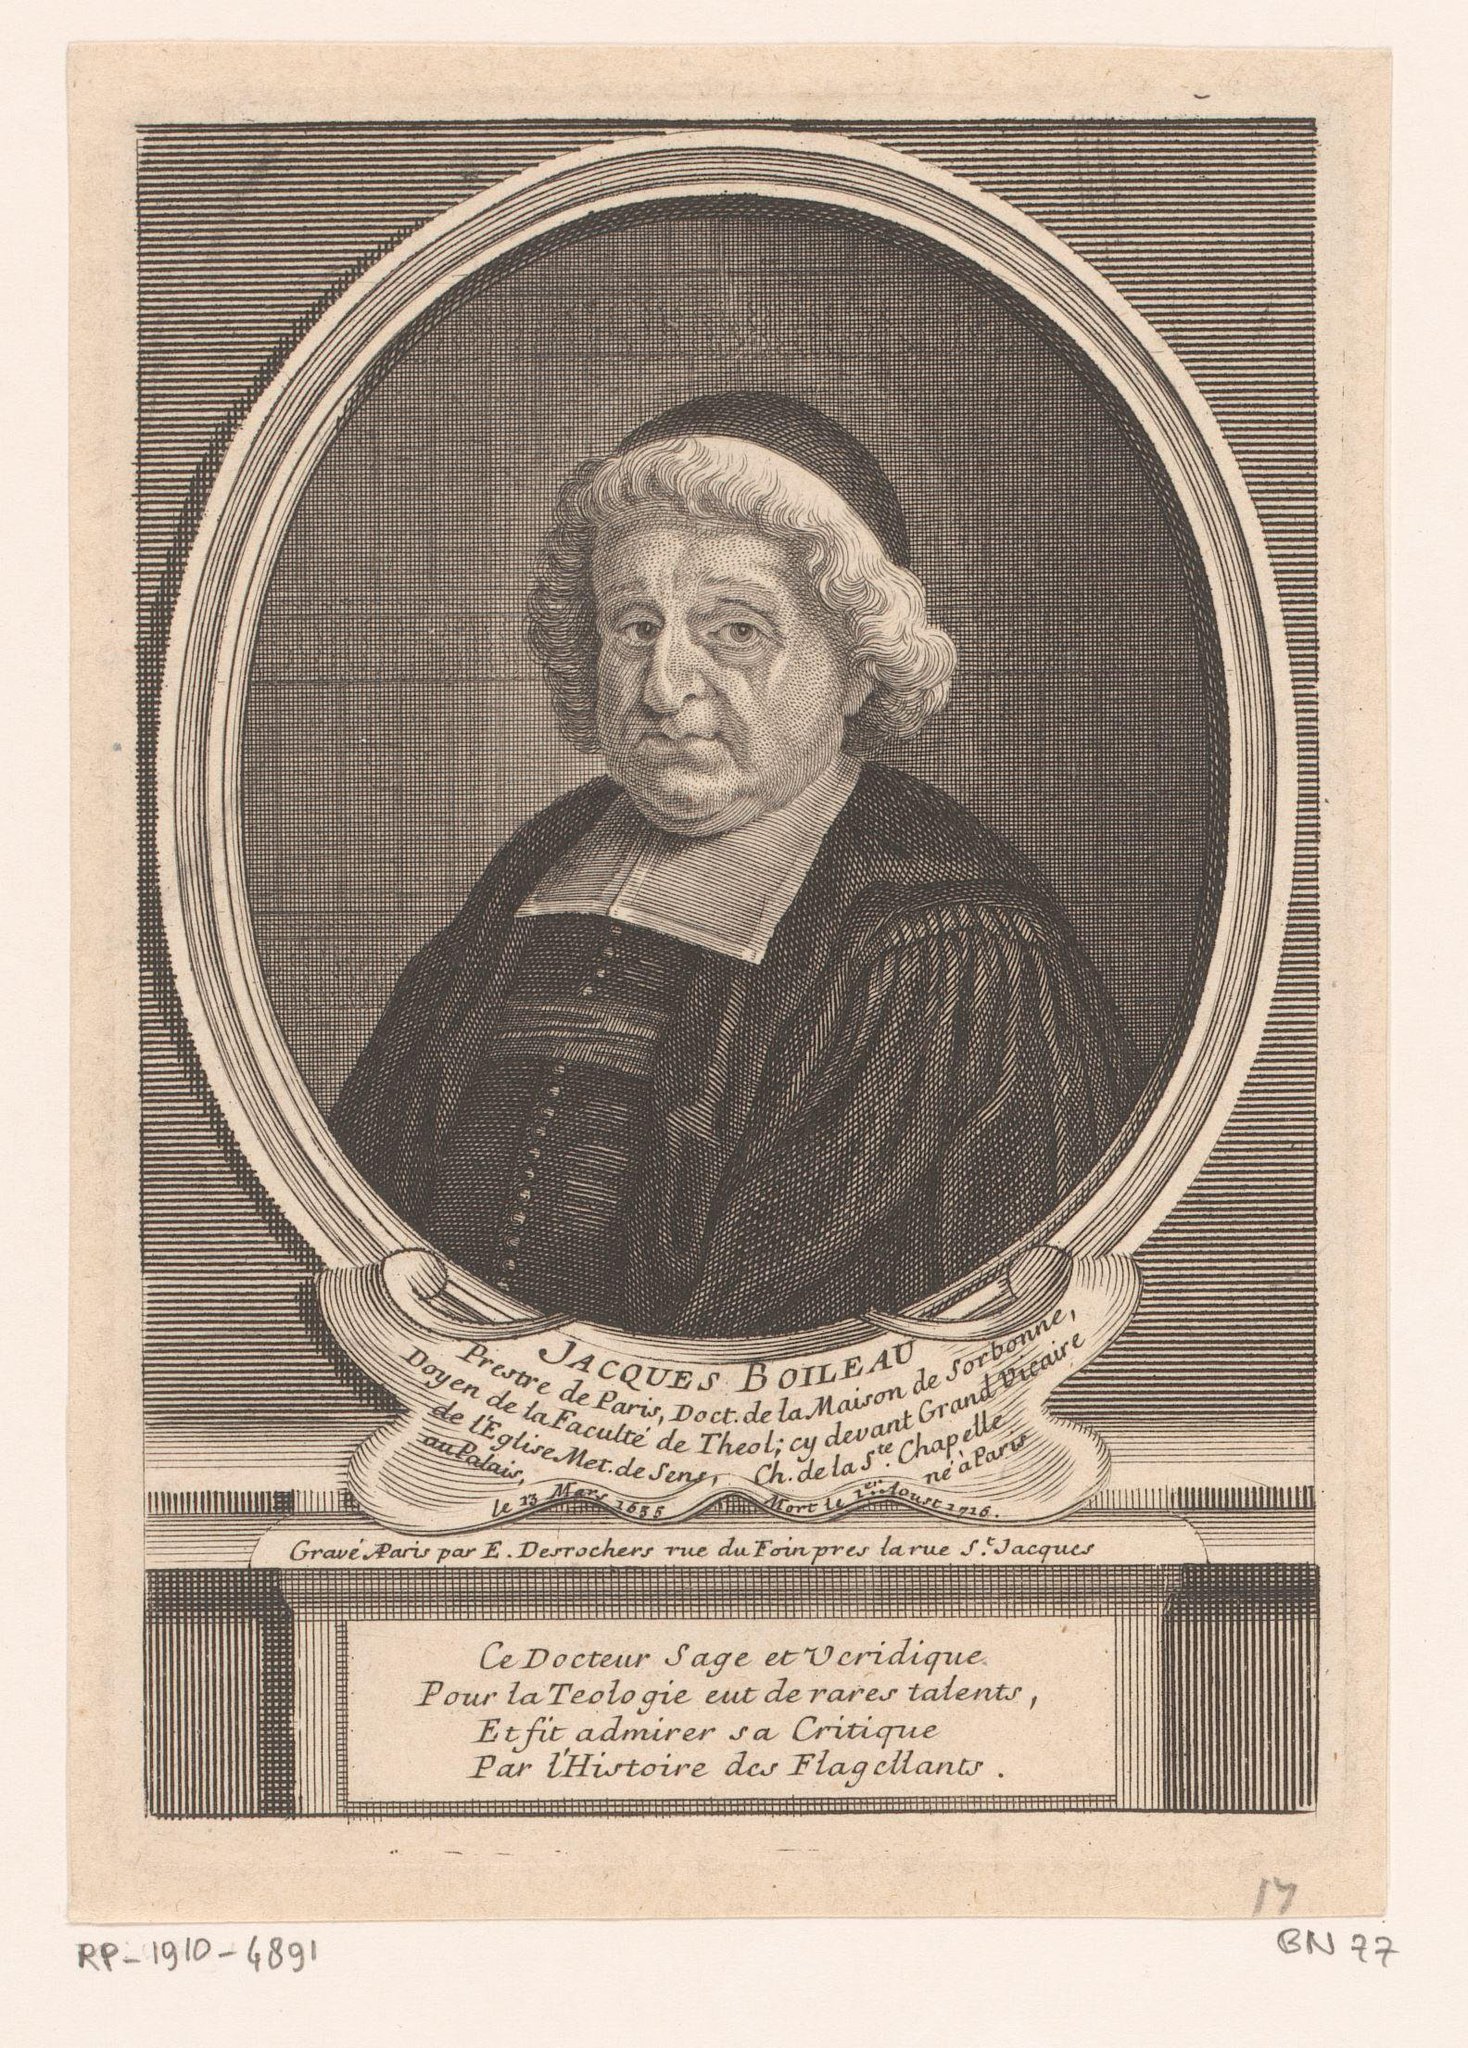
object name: print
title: Verzameling portretten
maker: étienne desrochers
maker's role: print maker, publisher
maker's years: 1668-1741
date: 1726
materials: paper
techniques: engraving, etching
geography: paris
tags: paris, historical persons, portrait of a writer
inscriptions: collector's mark: Lugt 2228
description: Behoort waarschijnlijk tot een serie portretten, grotendeels door Etienne Desrochers, getiteld: 'Recueil de portraits de personnes qui se sont distinguées tant dans les Armes que dans Belles-Lettres et les Arts, comme aussi la famille royale de France et autres cours étrangères'. De serie werd initieel uitgegeven door Desrochers en aangekondigd in 'Mercure' in mei 1726, p. 985. Echter was Desrochers reeds enkele jaren eerder begonnen met het uitgeven van de serie. Na de dood van Desrochers werd de serie voortgezet door Gilles Edme Petit. Een latere staat werd uitgegeven door Jean François Daumont in Parijs.